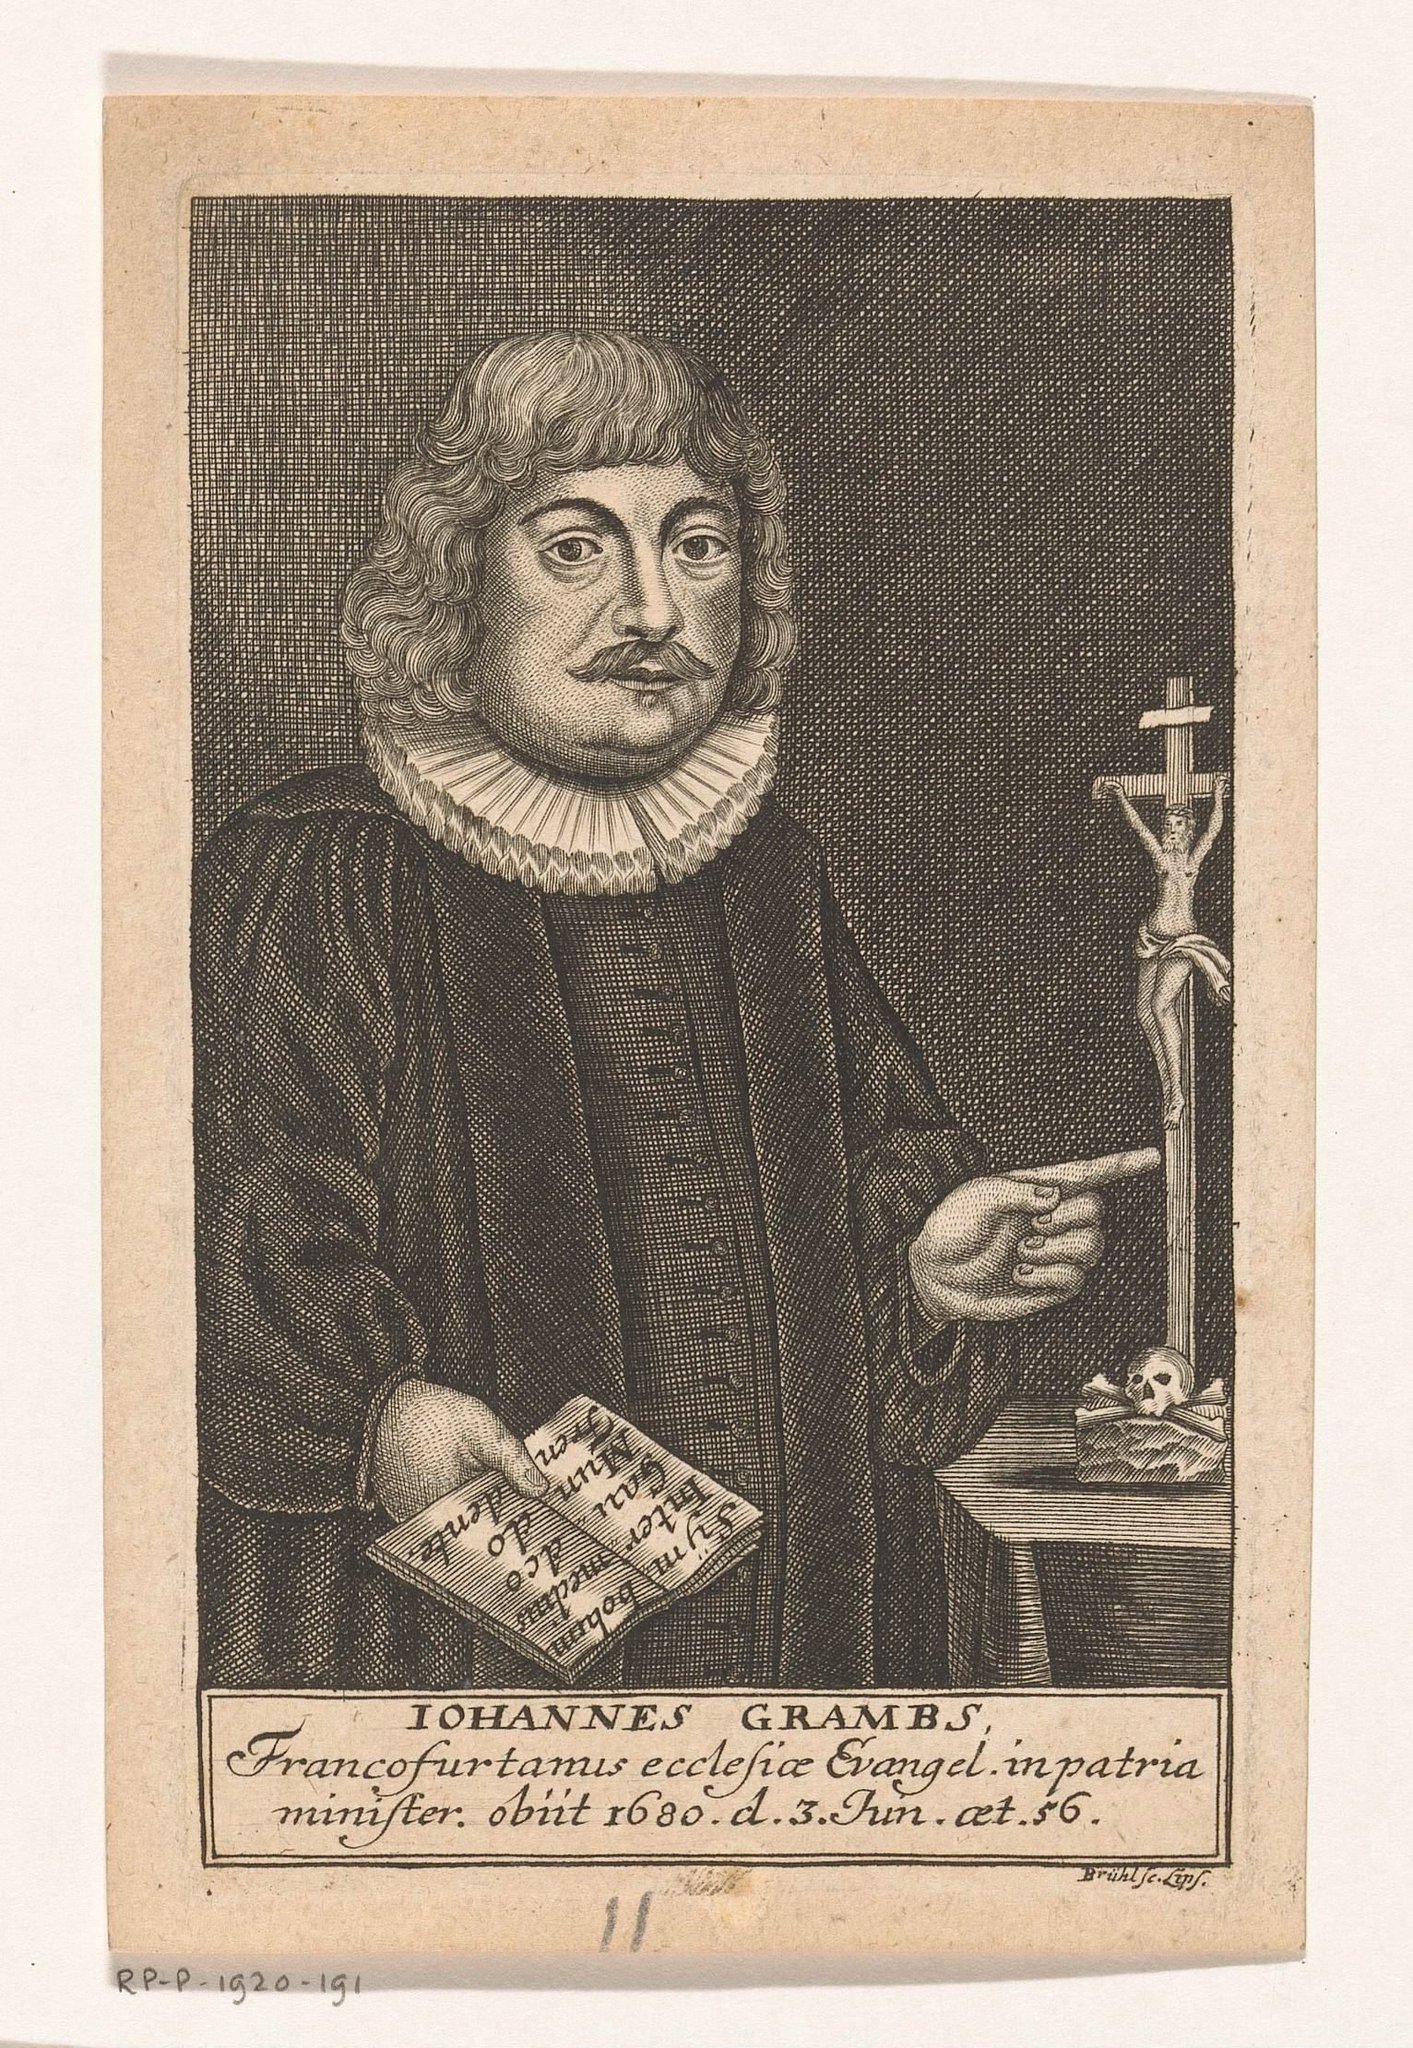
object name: print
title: Portret van Johann Grambs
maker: johann benjamin brühl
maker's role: print maker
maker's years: 1691-1763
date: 1729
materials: paper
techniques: engraving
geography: leipzig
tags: historical persons, book - mm - book open, crucifix ~ personal devotion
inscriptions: collector's mark: Lugt 2228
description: Prent ook gebruikt in: Fortgesetzte Sammlung Von Alten und Neuen Theologischen Sachen (...) Fünffter Beytrag Auf das Jahr 1729. Leipzig: erven Johann Friedrich Braun.